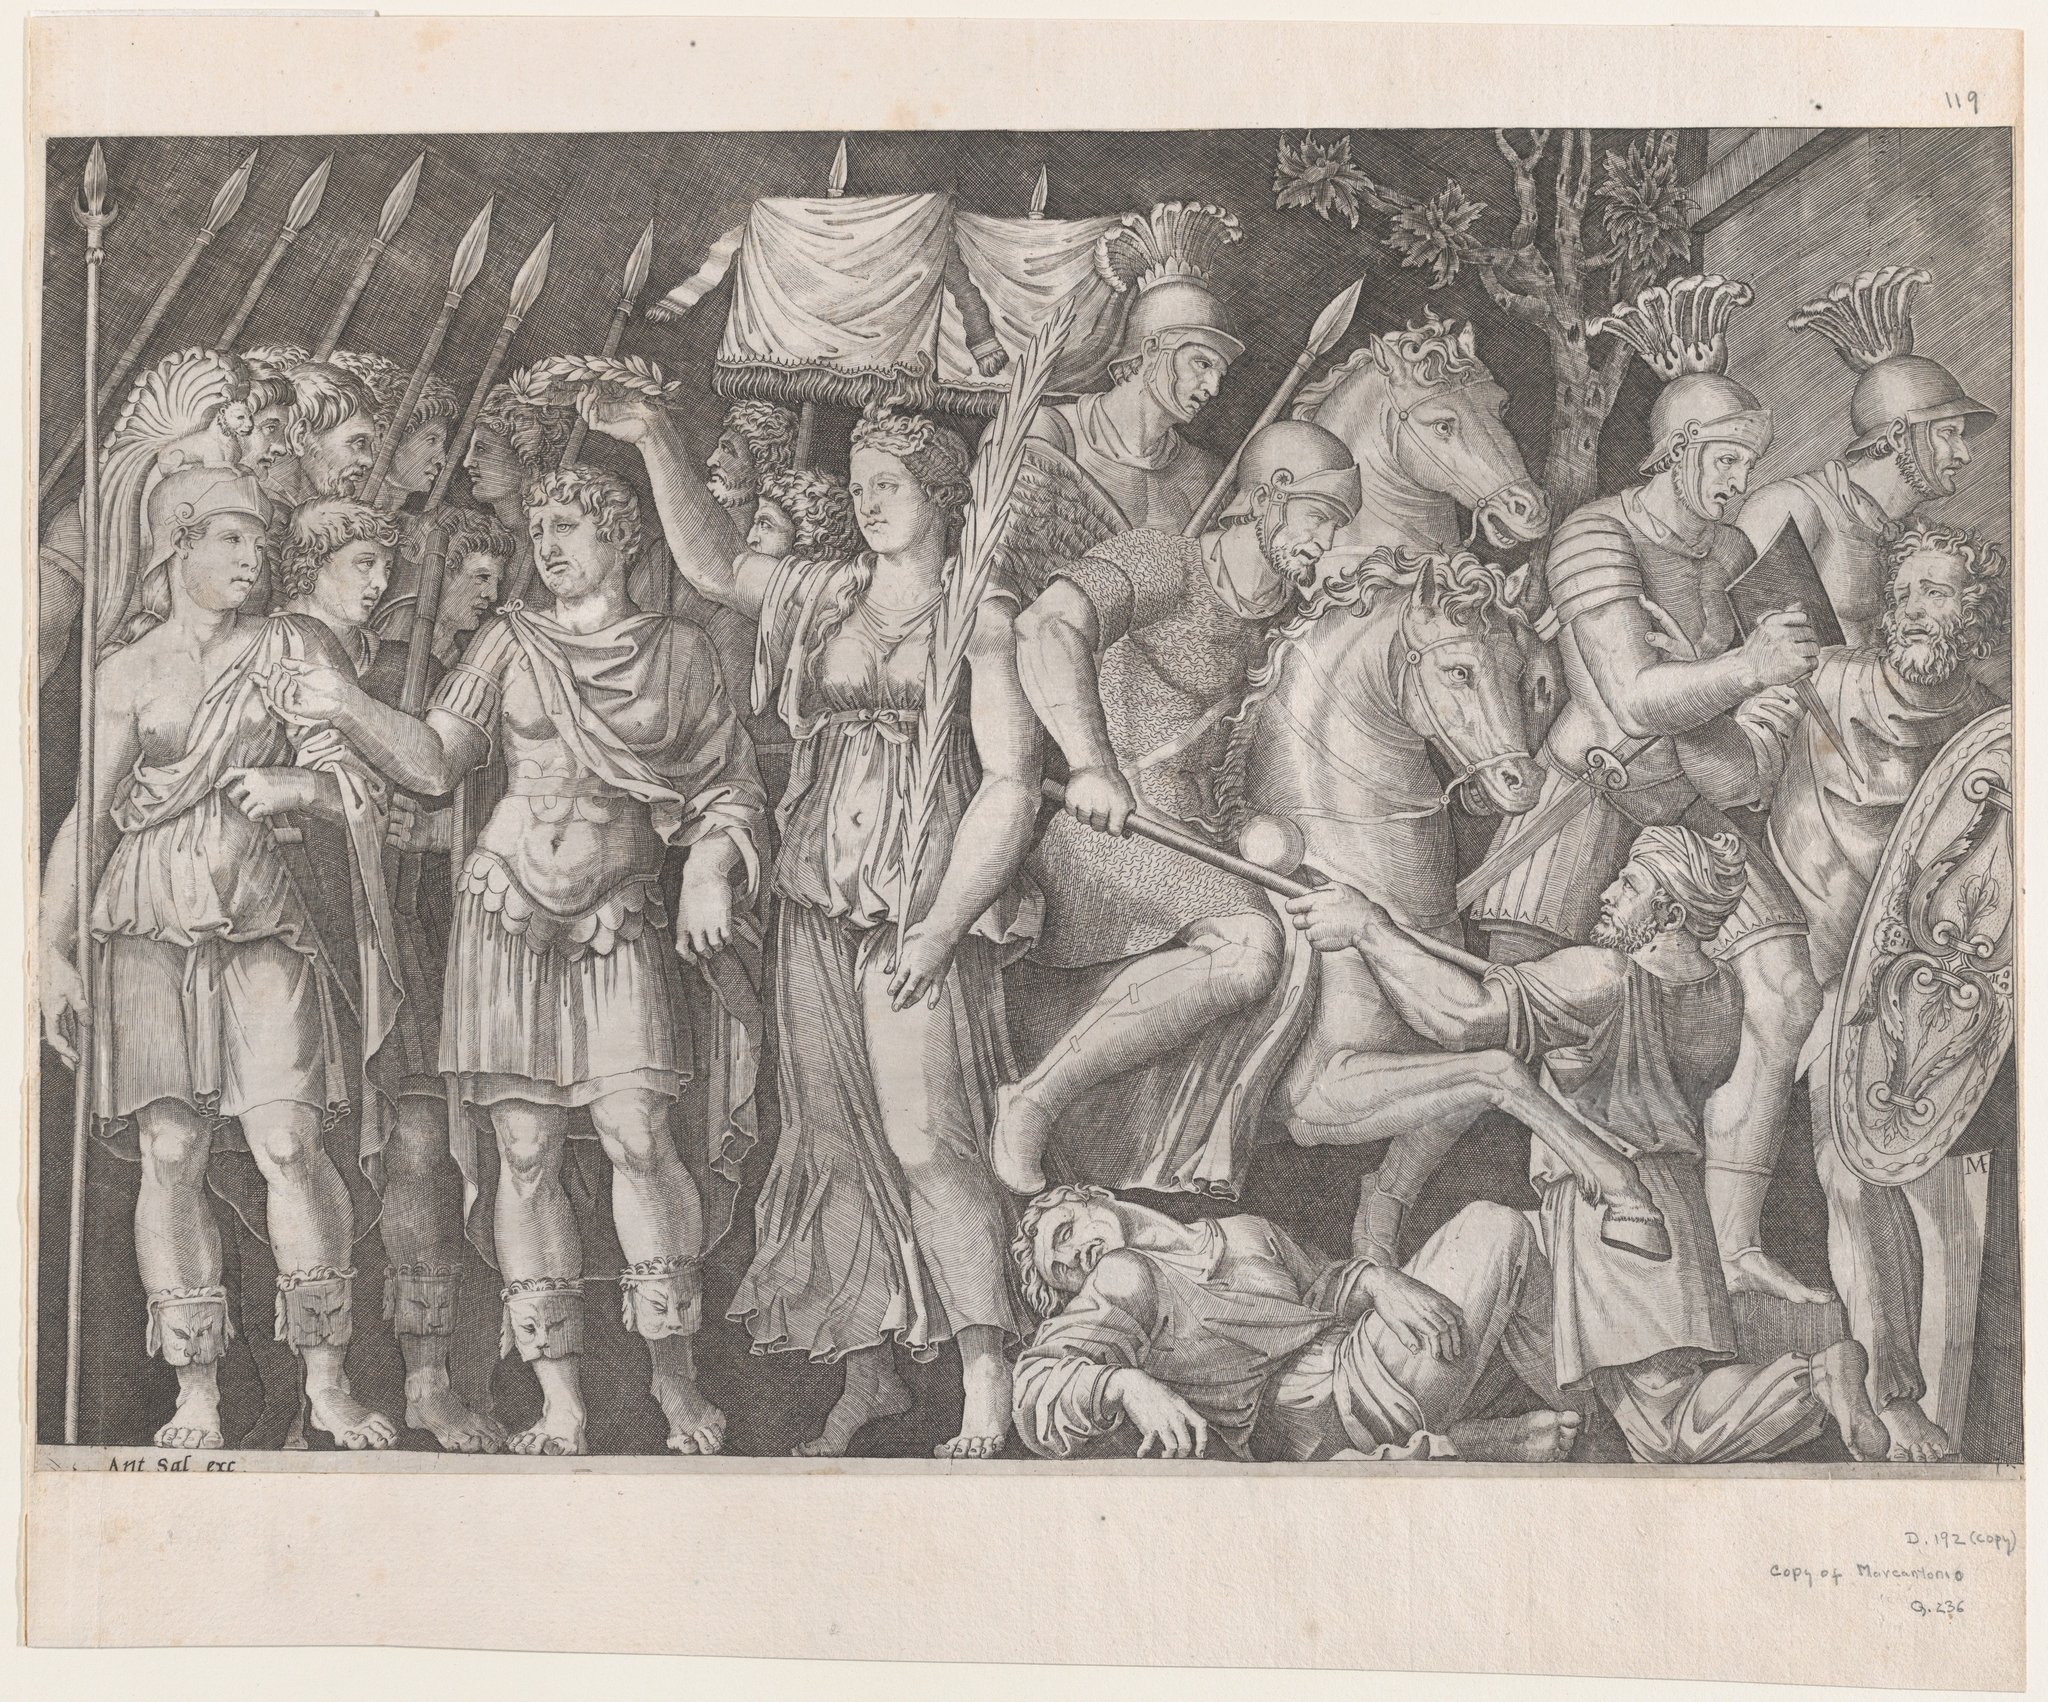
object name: print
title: Trajan Between City of Victory and Rome, from "Speculum Romanae Magnificentiae"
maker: anonymous, italian, 16th century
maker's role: artist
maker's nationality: italian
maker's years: 1550-1600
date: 1500-1534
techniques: engraving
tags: soldiers,spears,men,women,horses